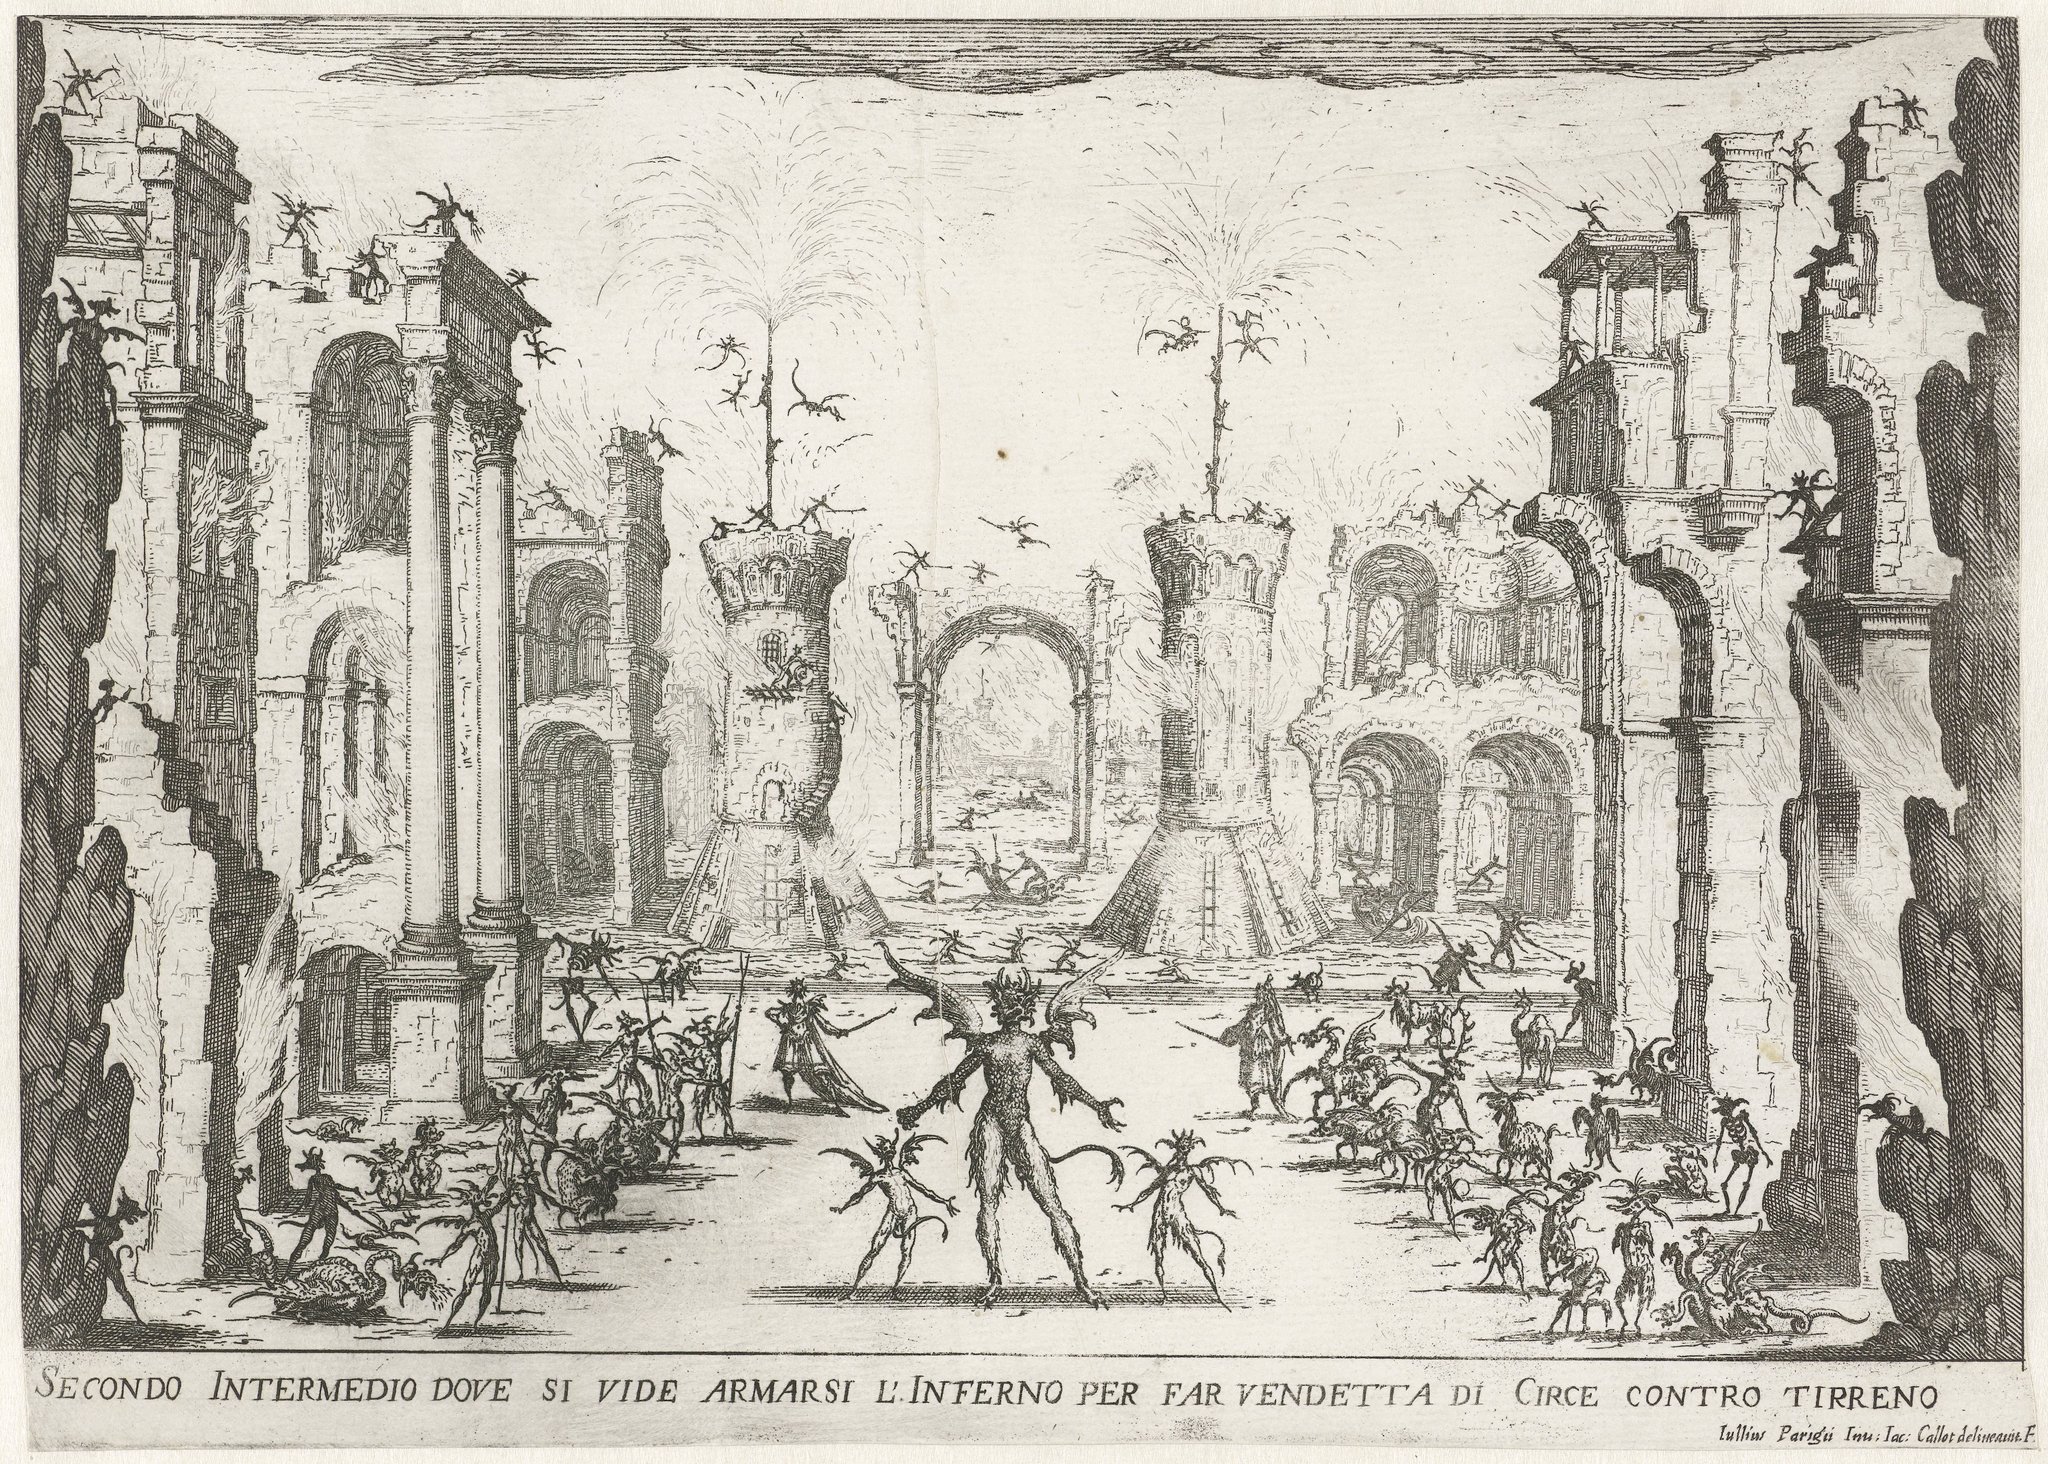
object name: print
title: Tweede intermezzo: helse wezens maken zich op om Circe te wreken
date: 1617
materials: paper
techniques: etching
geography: florence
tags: theatre, theatrical performance, devil(s) and demons, circe, hell represented as (ruined) city, (ruined) castle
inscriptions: collector's mark: Lugt 240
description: Op een toneel met brandende ruïnes en torens (een voorstelling van de hel) staat een grote duivel geflankeerd door twee kleinere op de voorgrond. Links en rechts achter hen demonen, op gesteld in twee rijen; her en der in de lucht, op het water en op de gebouwen op de achtergrond eveneens vele duivelse wezentjes. Onder de voorstelling een regel Italiaanse tekst. Deze prent is onderdeel van een serie van drie voorstellingen van intermezzi in het toneelstuk 'La Liberazione di Tirenno, e d'Arnea' van Andrea Salvadori, zoals dat uitgevoerd werd tijdens het carnavalsfeest te Florence in 1616.